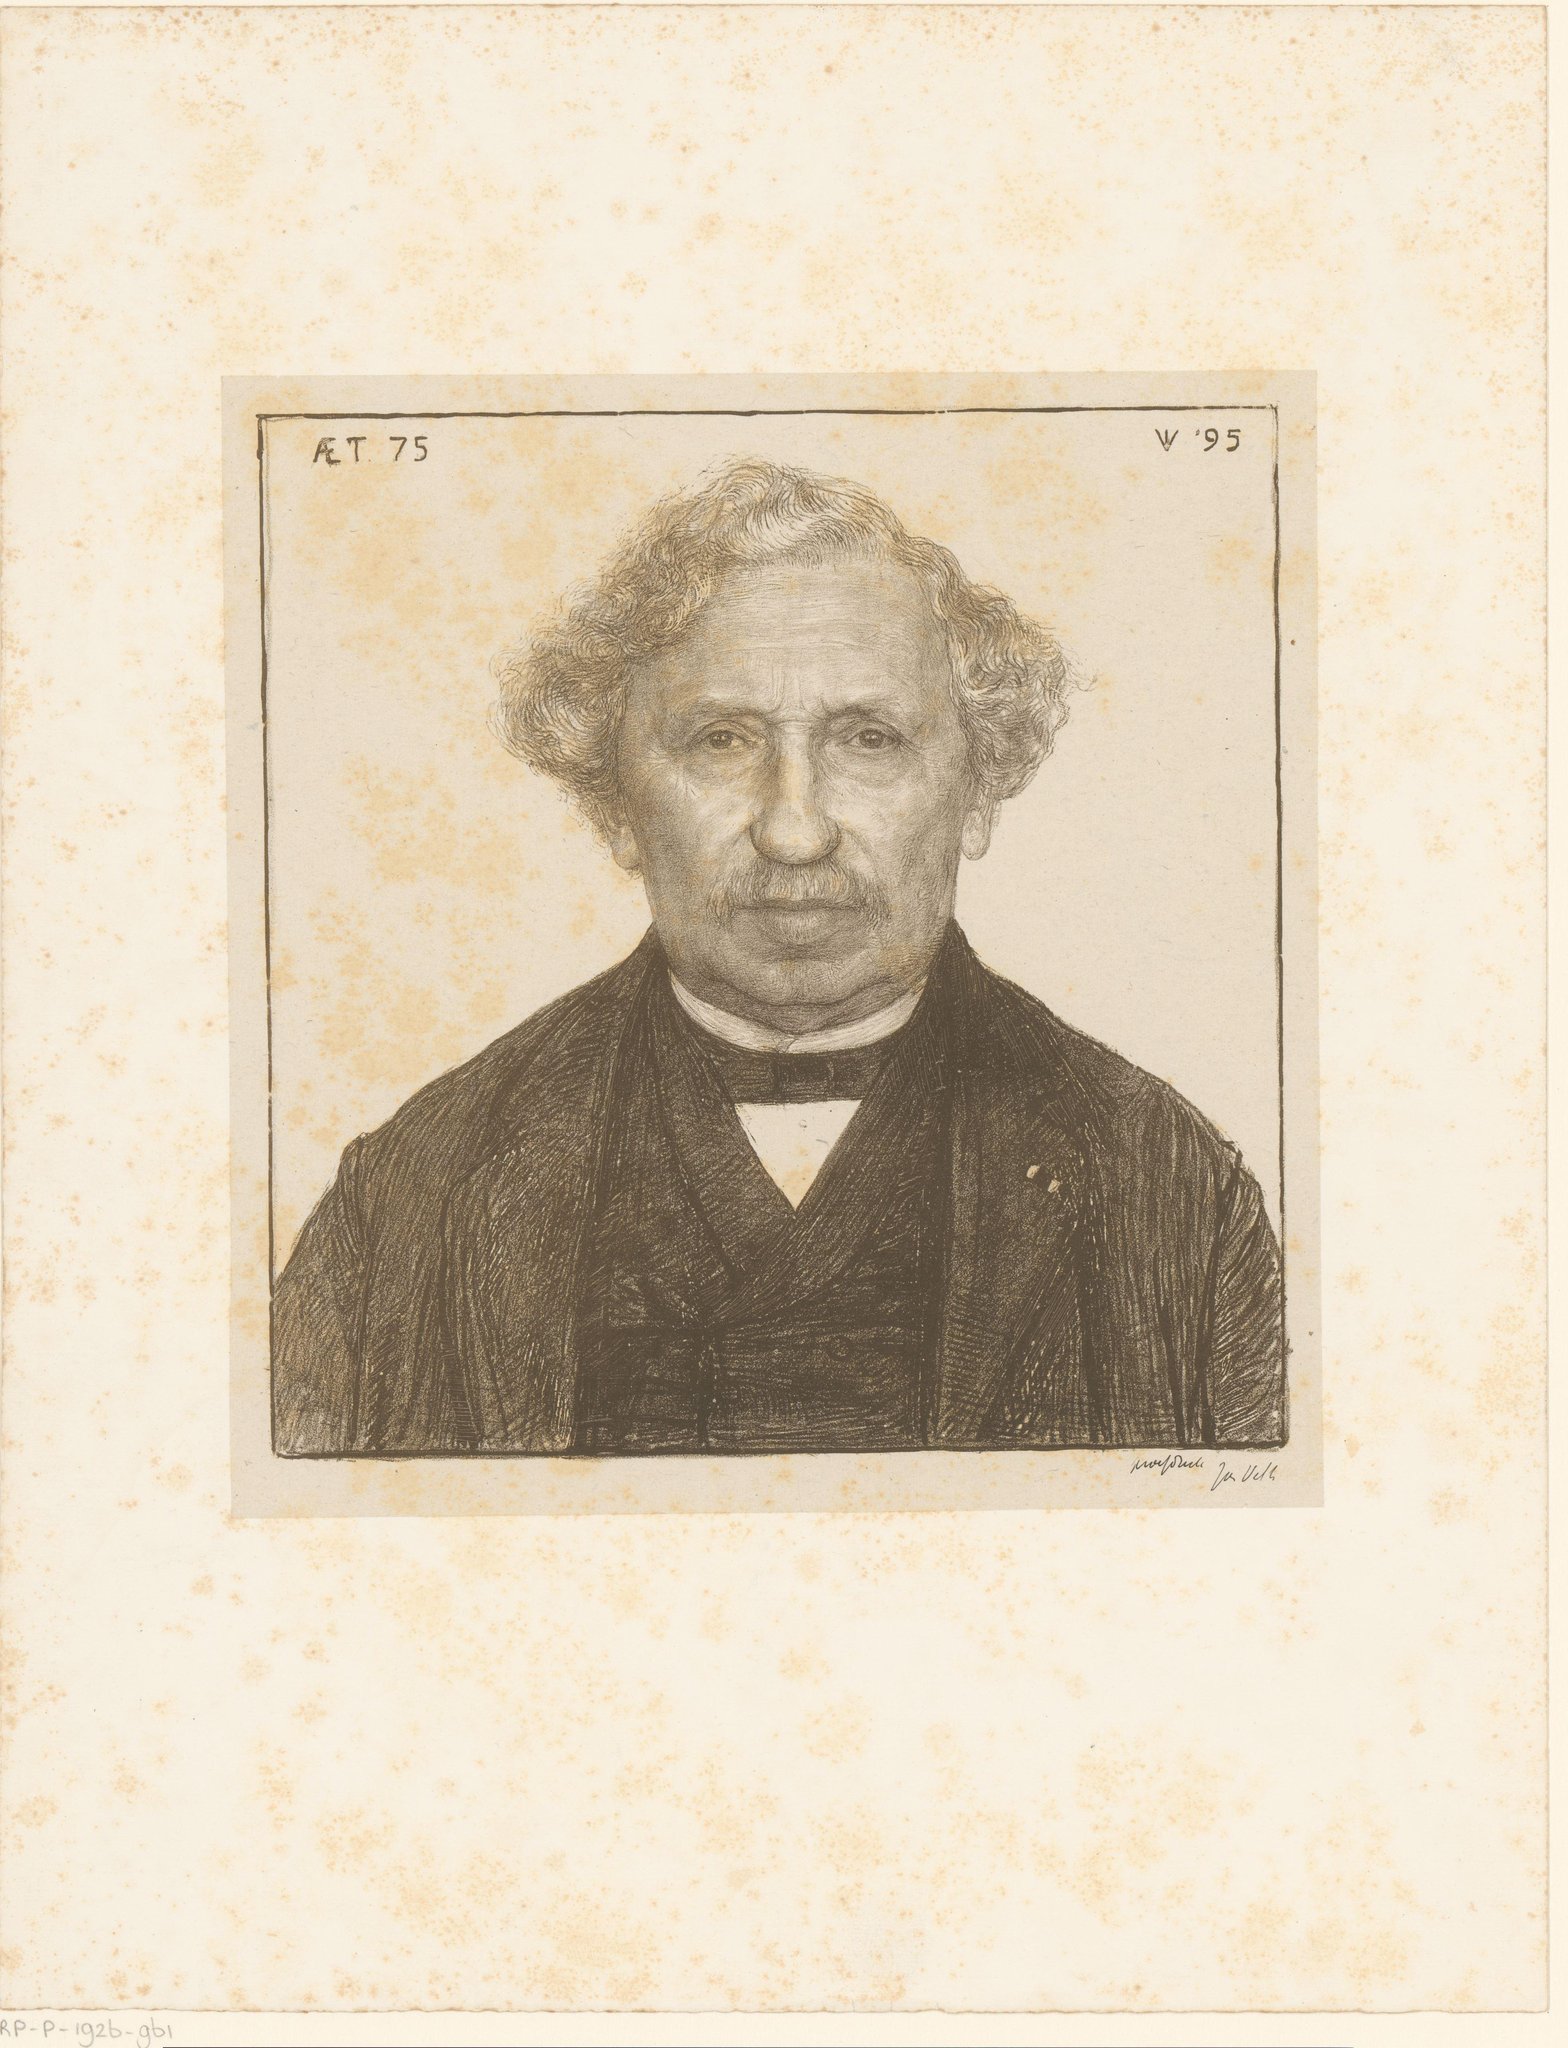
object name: print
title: Portretten van De Kroniek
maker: jan veth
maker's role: designer, draughtsman, painter, print maker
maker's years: 1864-1925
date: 1895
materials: paper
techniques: lithograph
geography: netherlands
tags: utrecht, historical persons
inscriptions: collector's mark: Lugt 2228, inscription: ‘proefdruk / Jan Veth’, collector's mark: ‘H.G. Samson Amsterdam’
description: Dit portret werd uitgegeven als bijvoegsel bij De Kroniek op 5 mei 1895.